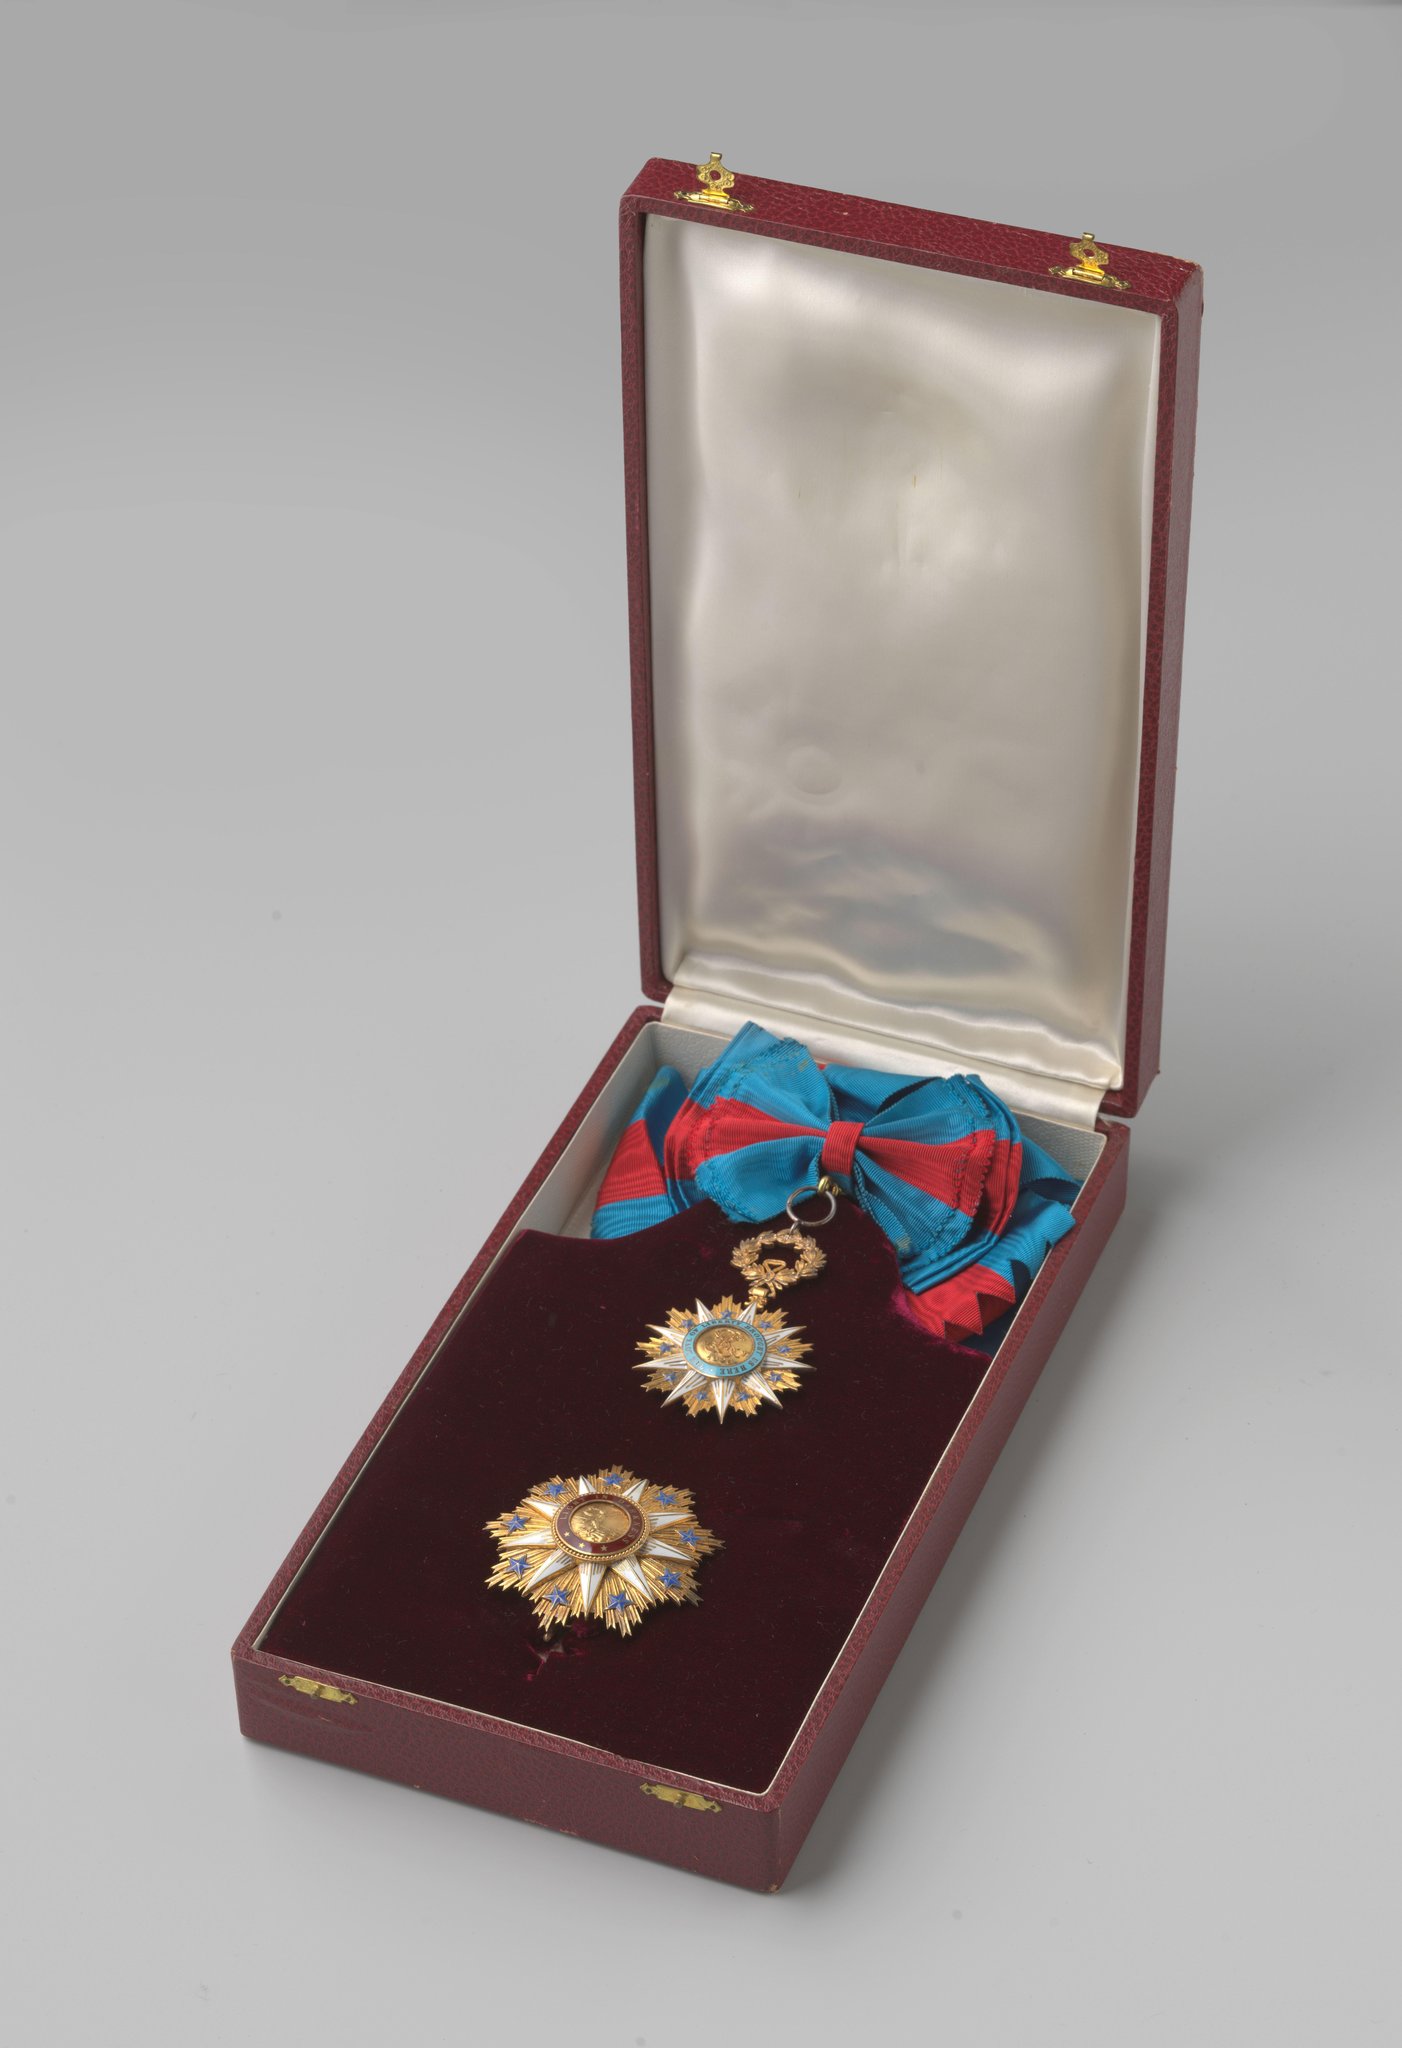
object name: ordeteken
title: Liberiaanse ridderorde (Order of the Star of Africa), ontvangen door Willem Drees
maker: Anonymous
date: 1950-1960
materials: gold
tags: amsterdam, willem drees, netherlands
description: Het tweezijdige draagteken bestaat uit een negenpuntige, wit geemailleerde gouden ster, waartussen negen gouden punten van stralen waarop negen kleine vijfpuntige blauwe sterren; in het midden een gouden medaillon met ineengevlochten de letters R L, waaronder 1920, met omschrift in gouden letters op lichtblauwe ondergrond 'The love of liberty brought us here'. De keerzijde heeft als medaillon in goud een figuur en profil naar rechts gekeerd die de handen gestrekt ten hemel heft, met als omschrift op dieprode ondergrond 'Light in darkness'. Het draagteken is met een oog aan gouden krans van bladeren verbonden, die met draagoog vastzit aan lichtblauw draaglint met rode baan in midden.